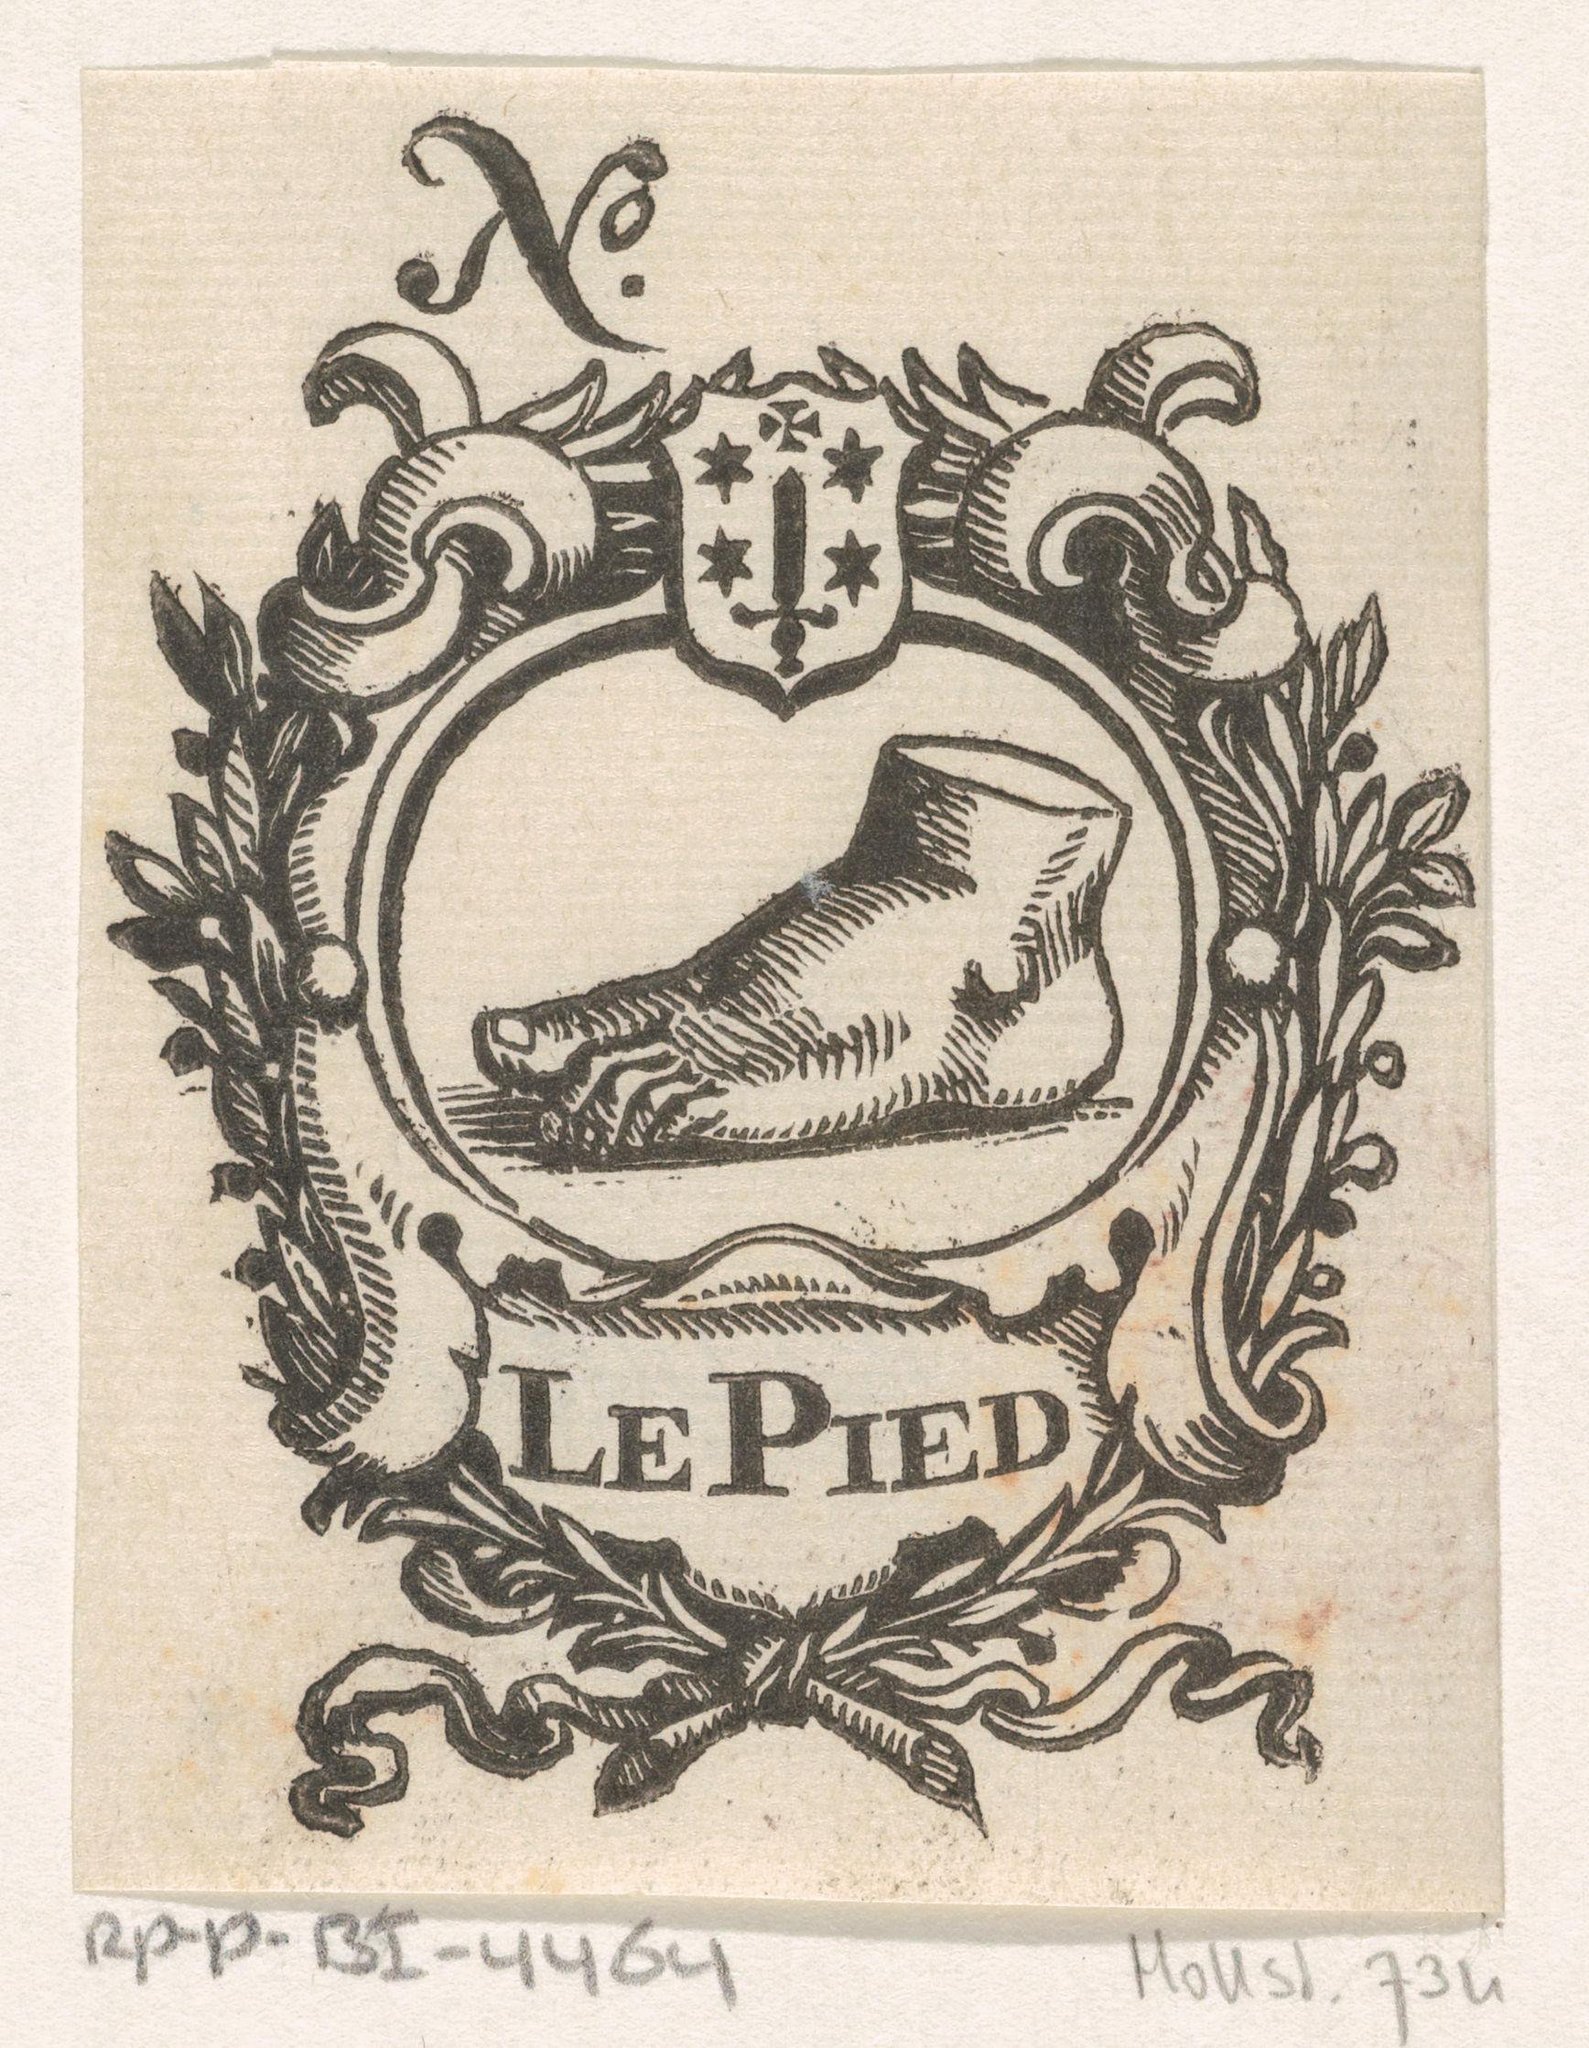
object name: handelsetiket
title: Handelsetiket met een voet in een lauwerkrans en het wapen van de stad Haarlem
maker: isaac vincentsz. van der vinne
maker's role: draughtsman, print maker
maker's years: 1665-1740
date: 1681-1740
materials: paper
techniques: woodcut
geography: haarlem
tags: coat of arms (as symbol of the state, etc.) (+ city; municipal), foot, vignette, haarlem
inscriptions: collector's mark: Lugt 240